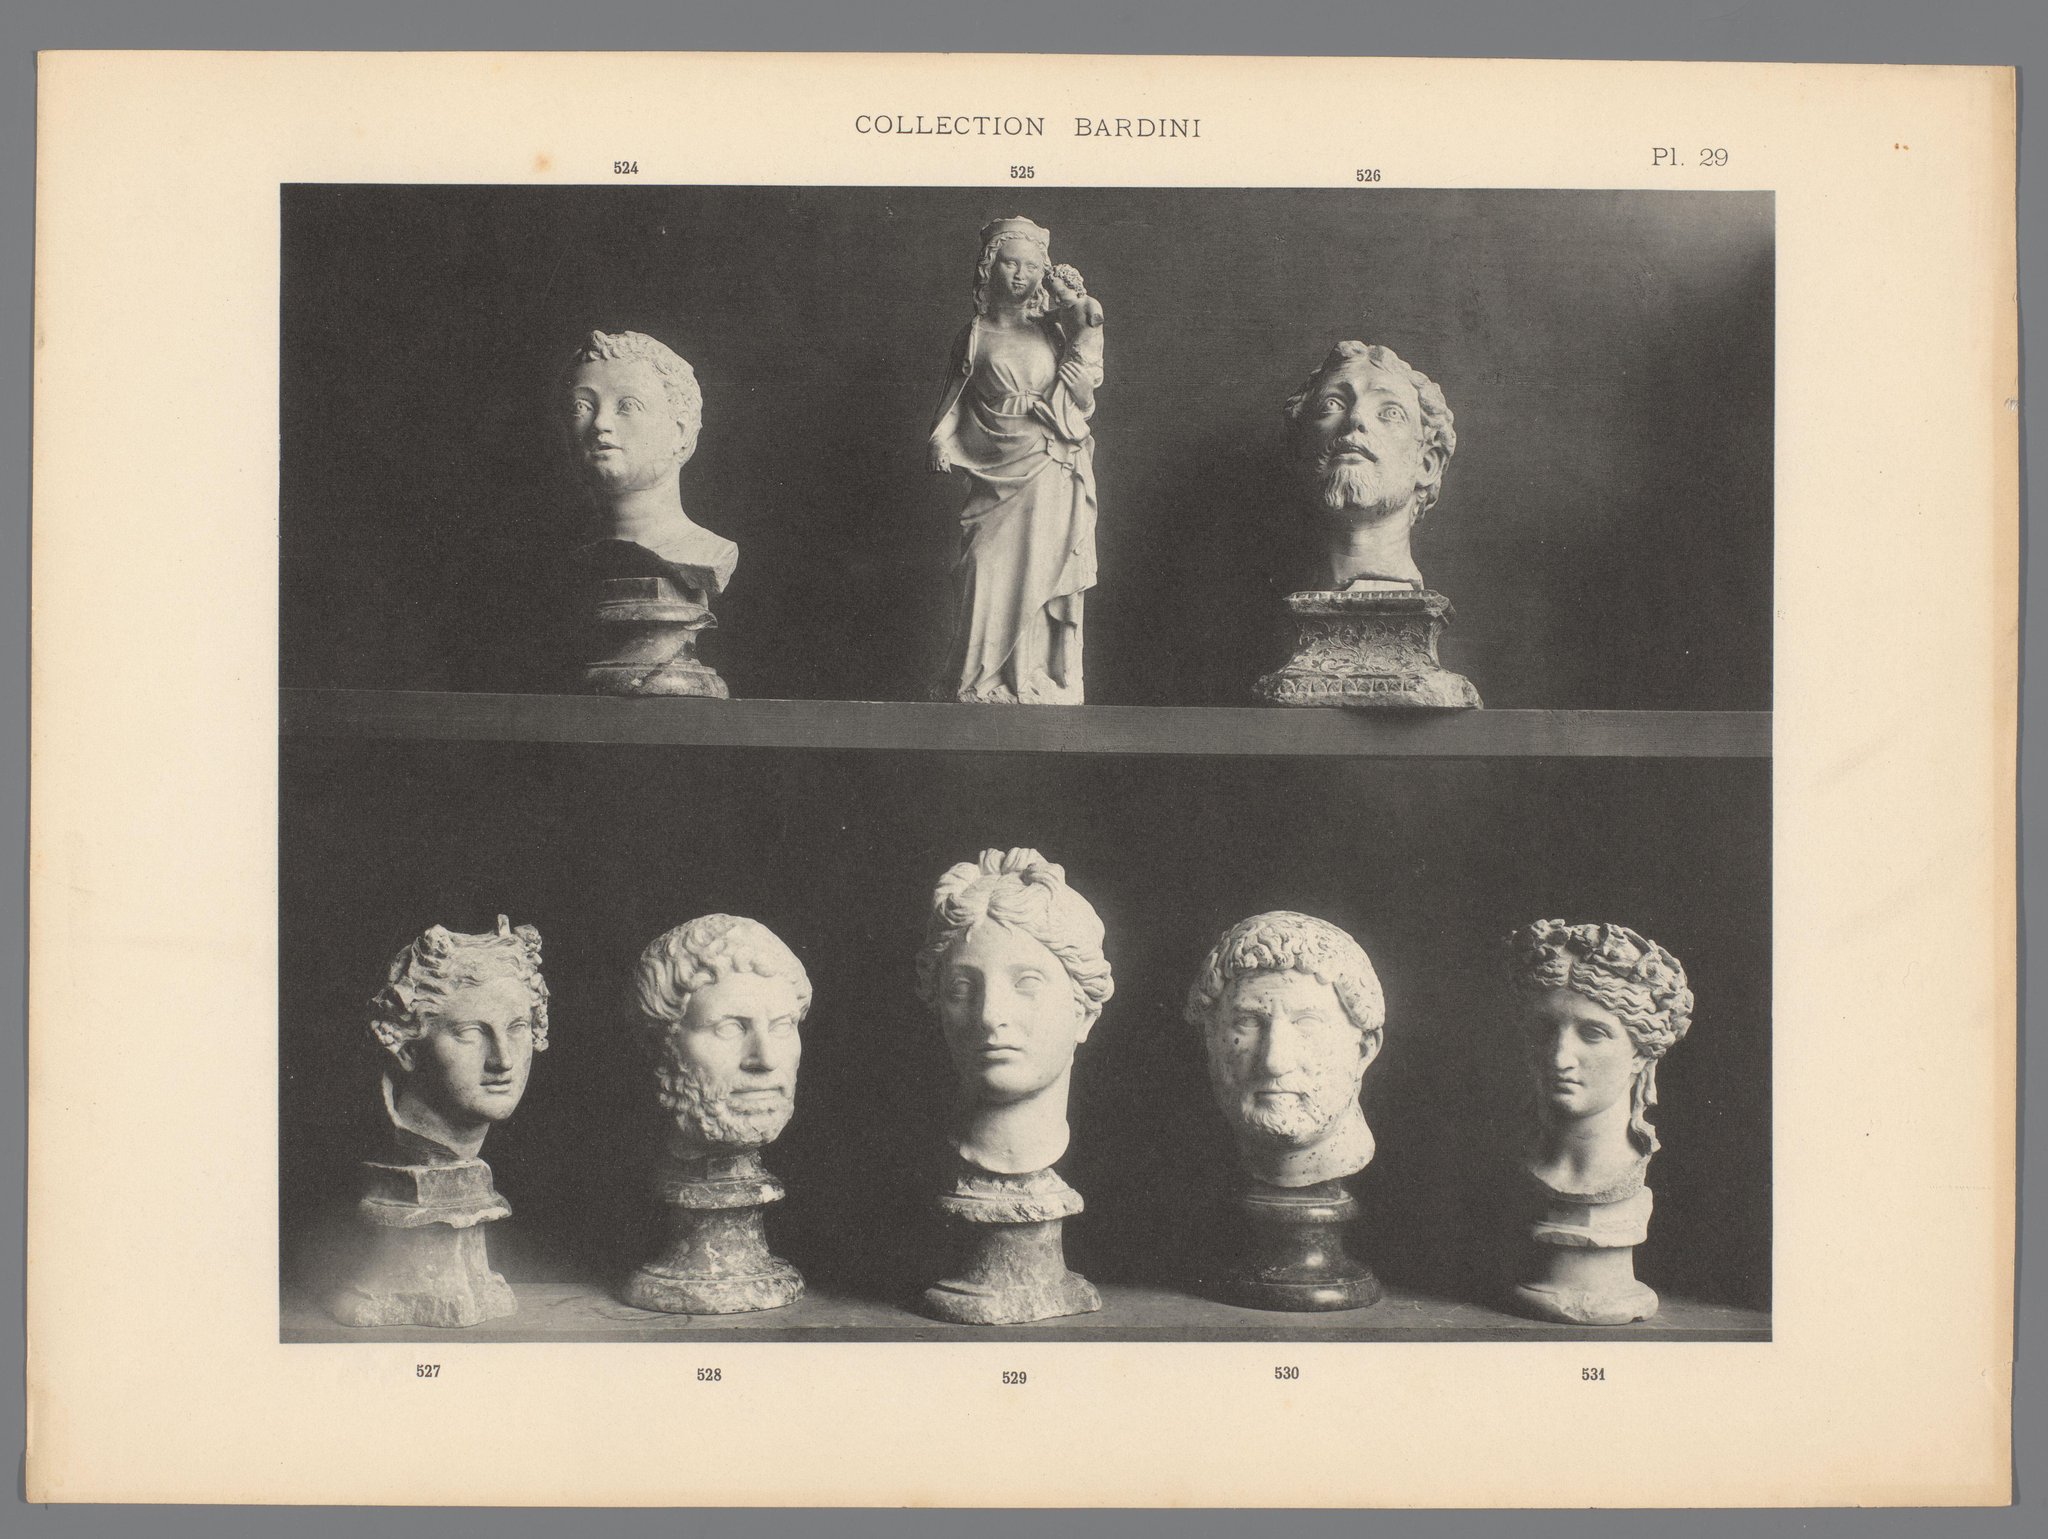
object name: photomechanical print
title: Verzameling van een Mariabeeld en sculpturen van hoofden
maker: Anonymous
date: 1875-1930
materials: paper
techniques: photograph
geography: florence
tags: head (human), sculpture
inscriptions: number: ‘Pl. 29’